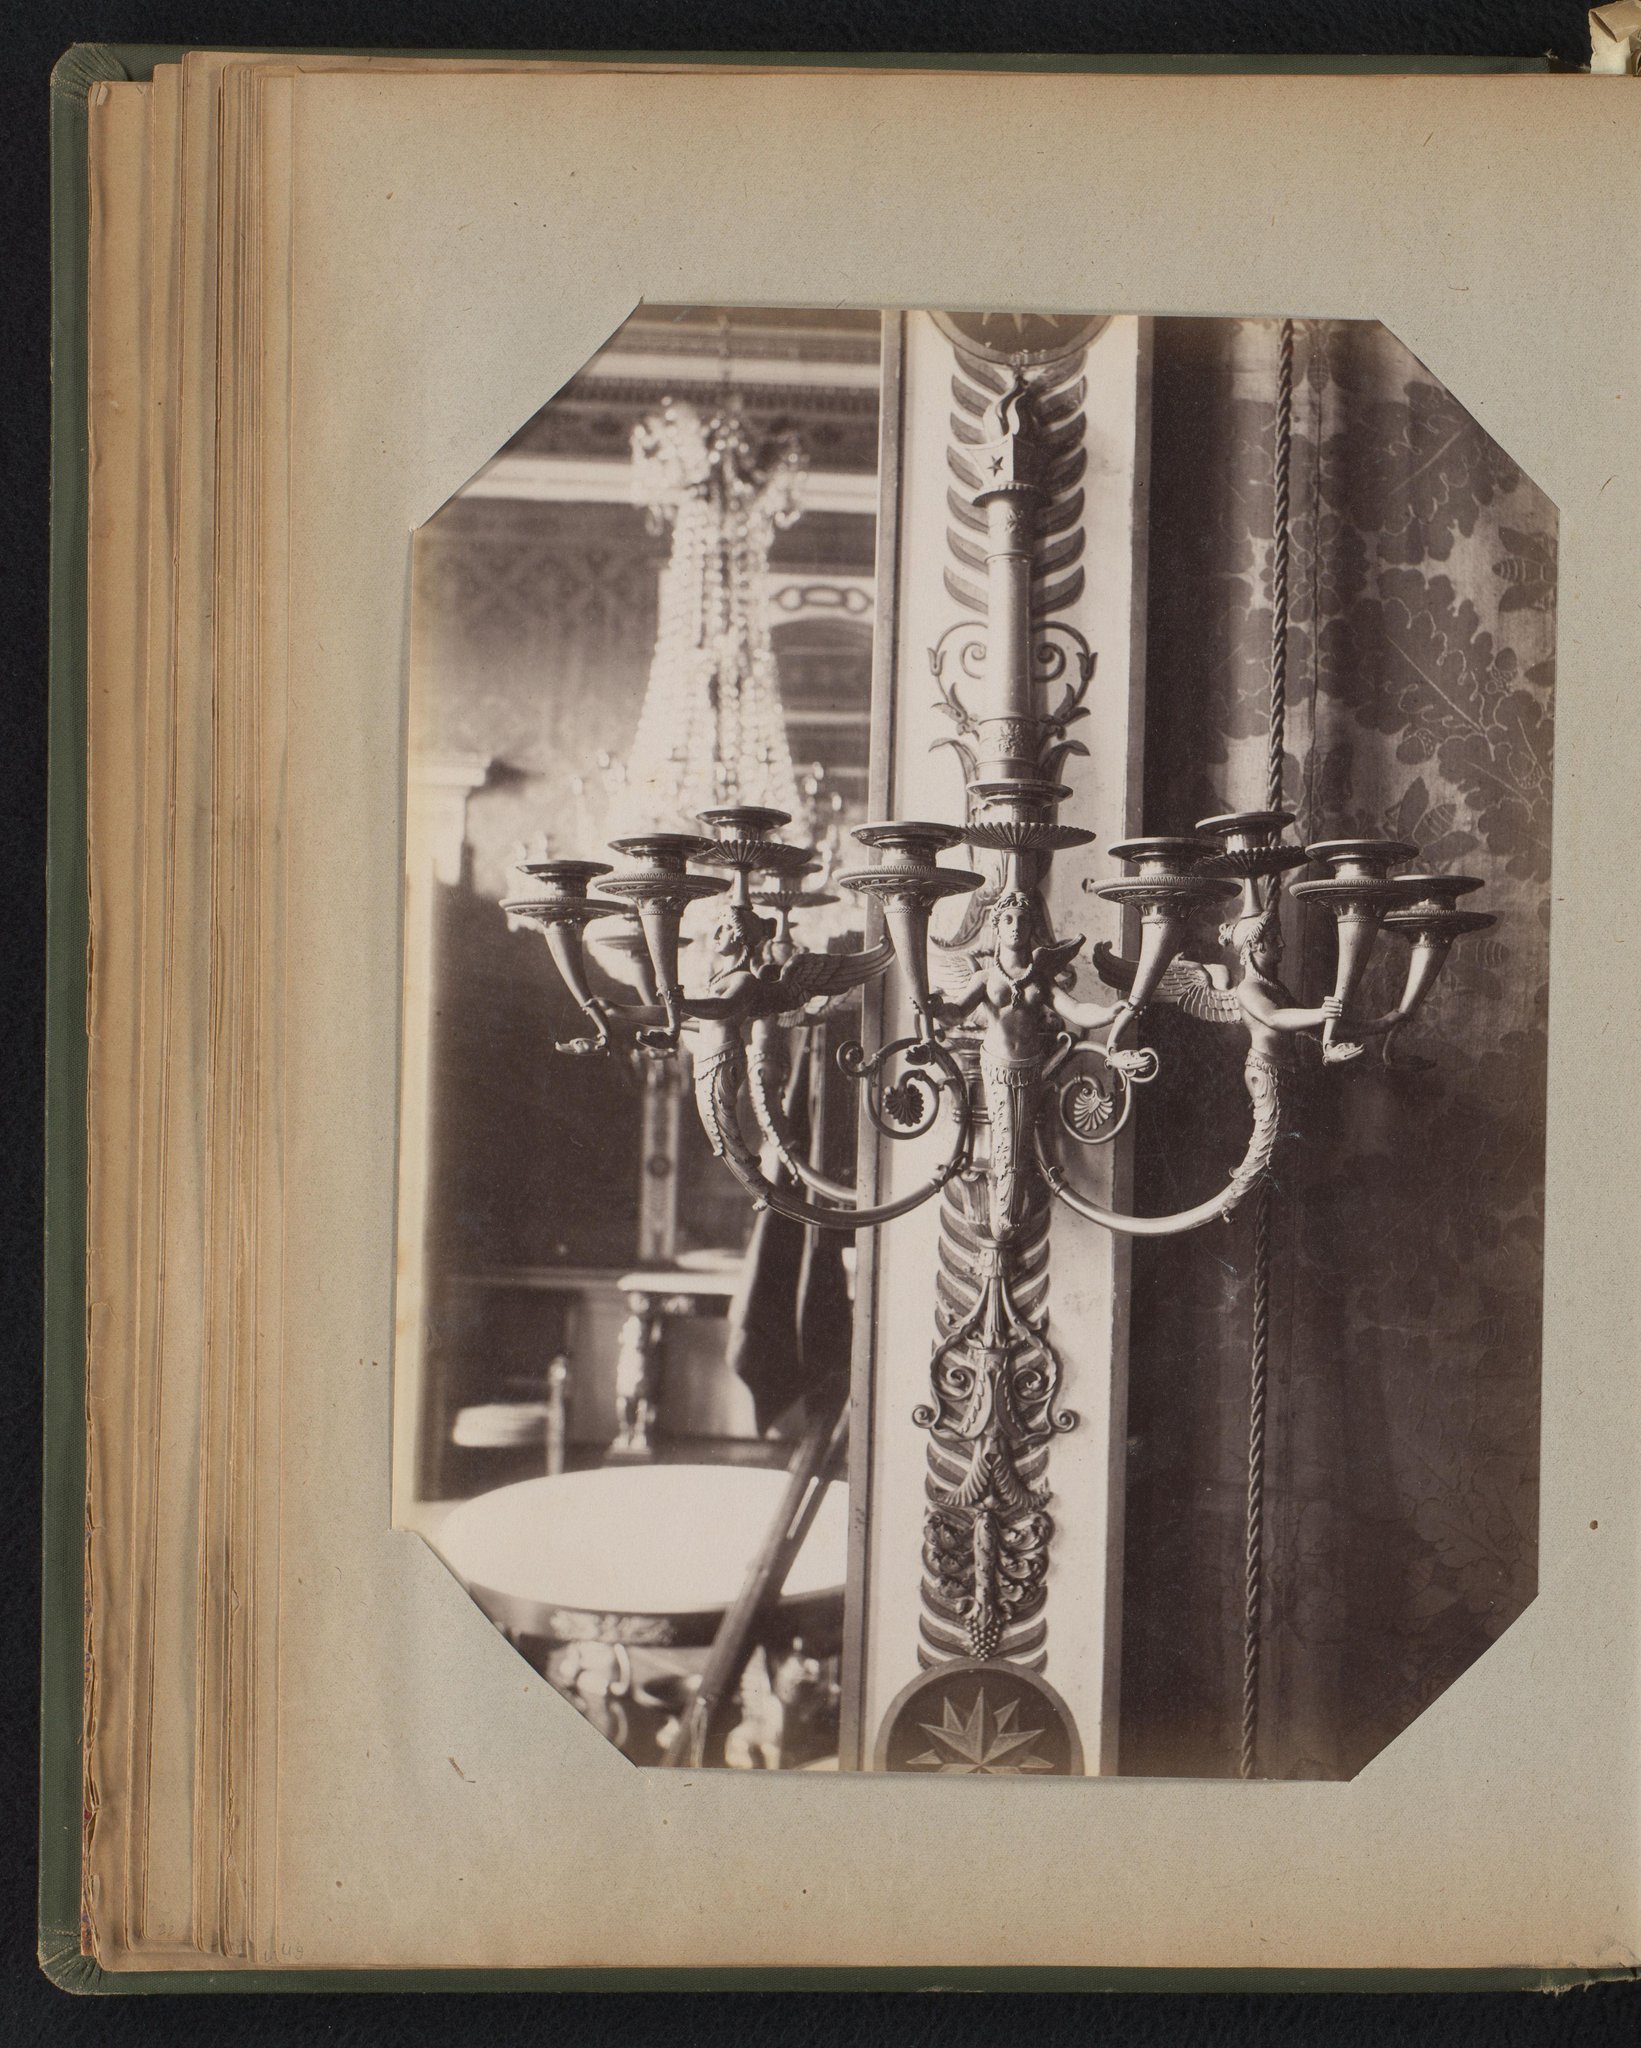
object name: photograph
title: Bronzen negenarmige muurkandelaar met mythologische figuren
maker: Anonymous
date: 1860-1900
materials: paper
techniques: albumen print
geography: france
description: Drie bronzen, gevleugelde vrouwen houden ieder twee zwanenhalsen vast die uitlopen in kandelaars. Onderdeel van een serie met betrekking tot het interieur van het paleis van Versailles met kroonluchters, deuren, portalen en meubelstukken.